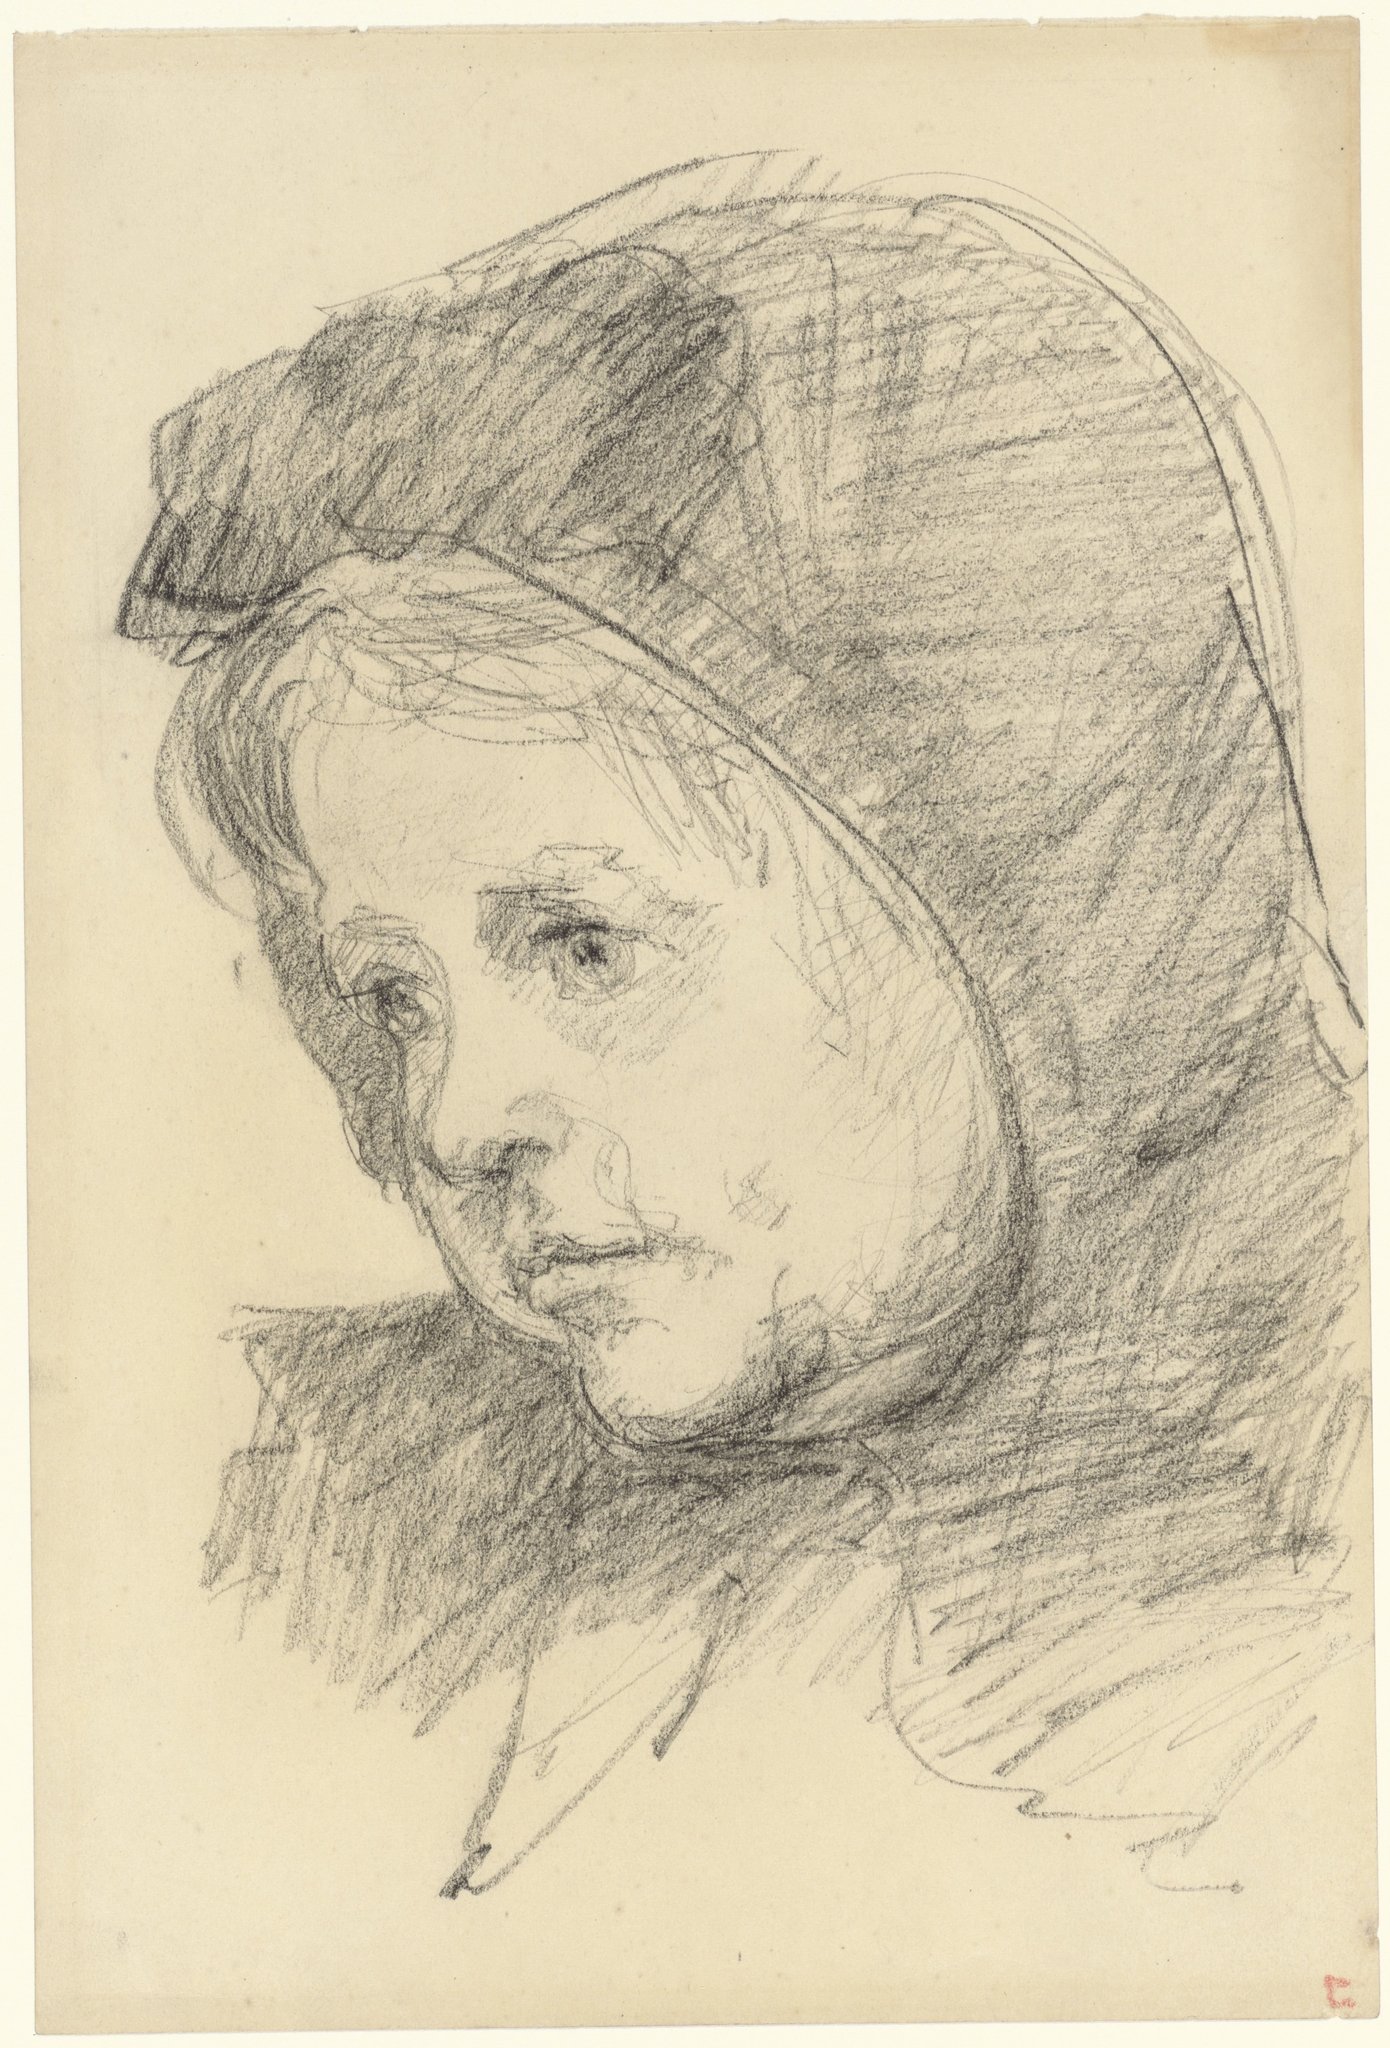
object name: drawing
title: Kinderkopje met muts, naar links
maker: jozef israëls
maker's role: draughtsman, painter, print maker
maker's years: 1824-1911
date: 1834-1911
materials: chalk, paper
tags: anonymous historical person portrayed alone